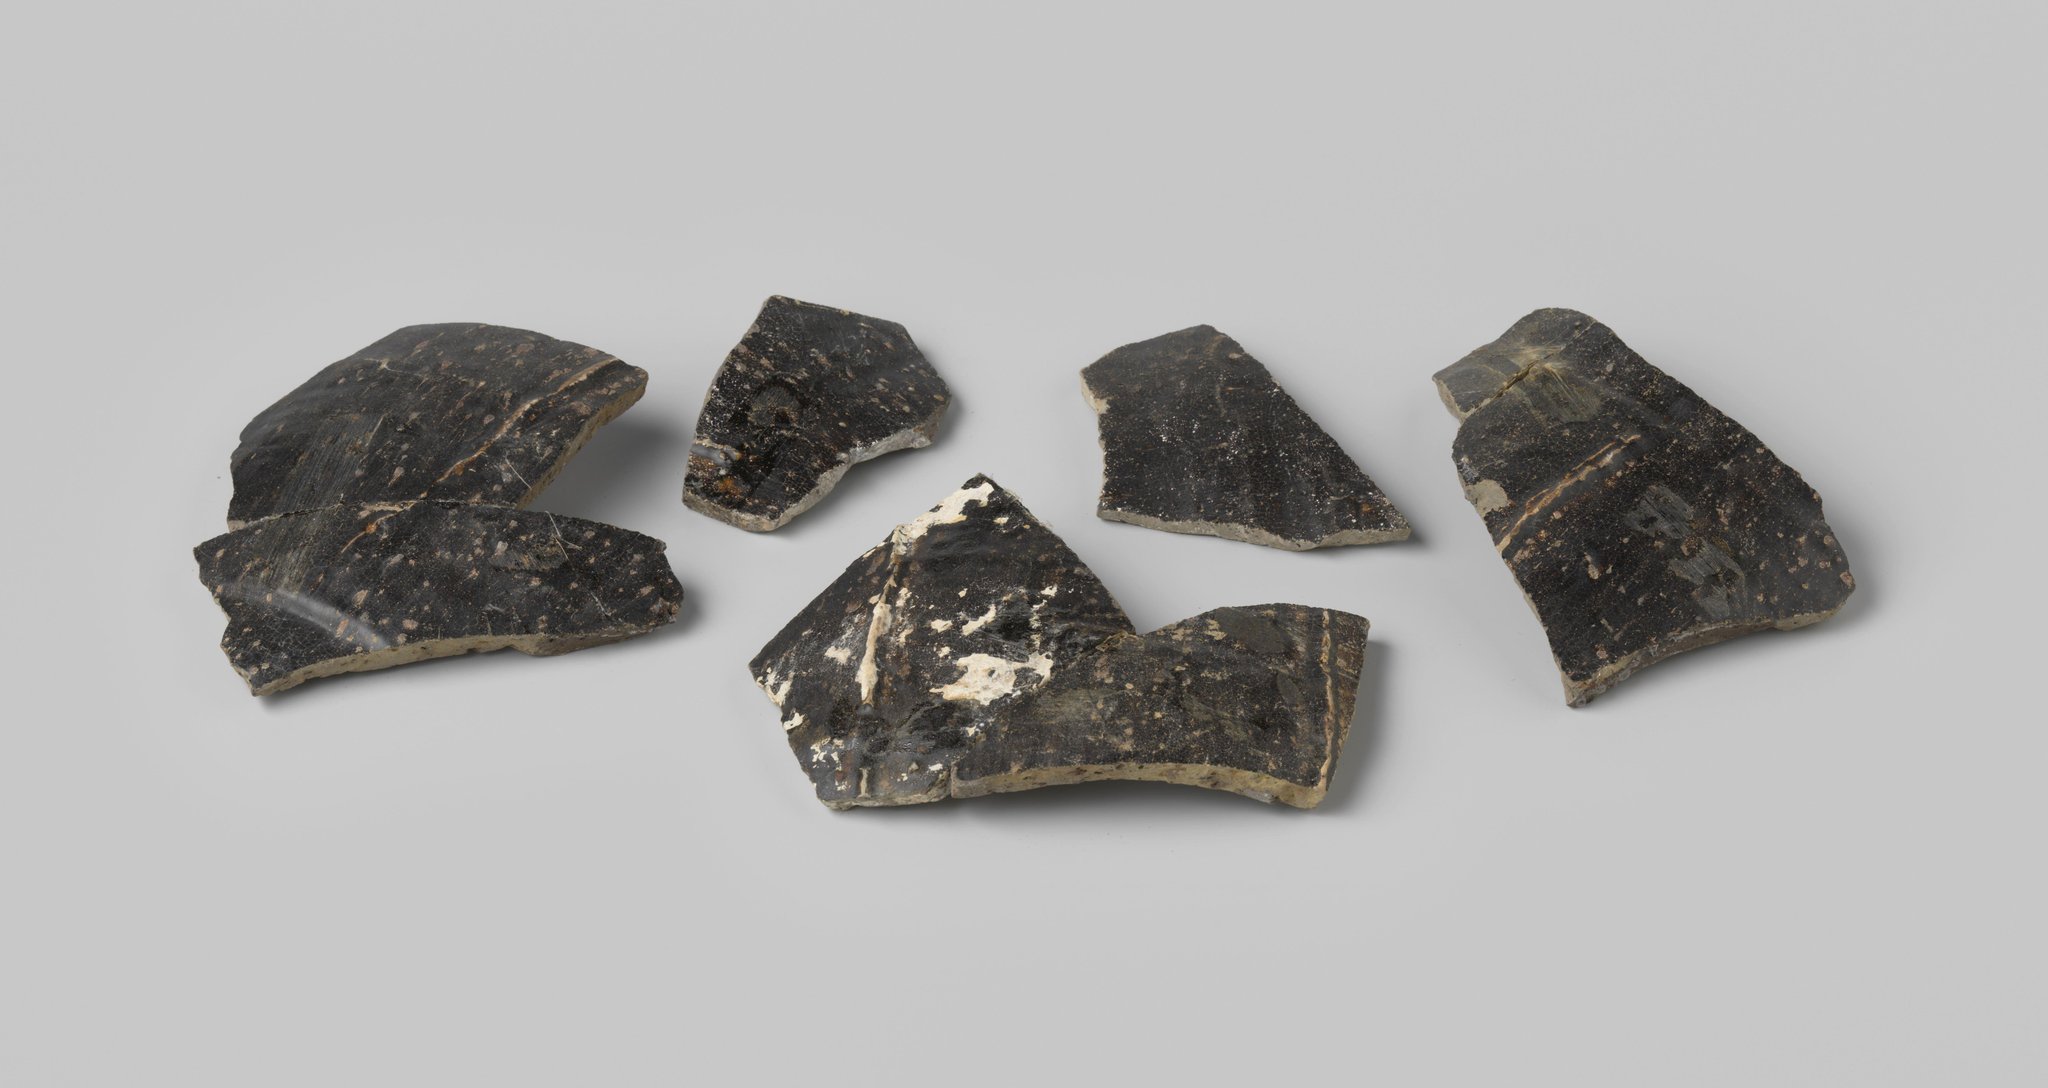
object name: sherd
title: Fragment van een martavaan uit V.O.C.-schip de 'Witte Leeuw'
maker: Anonymous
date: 1613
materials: porcelain, stoneware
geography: martaban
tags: verenigde oostindische compagnie, sint-helena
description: A jar. The upper part of the jar is glazed and long trickles run down. On the inside, the lip, neck and shoulders joint are glazed. Between the neck and shoulder, there is an unbroken dotted band. From this band vertical bands run down halfway the body. The jar has been made in two parts, of which the lower part is smaller.